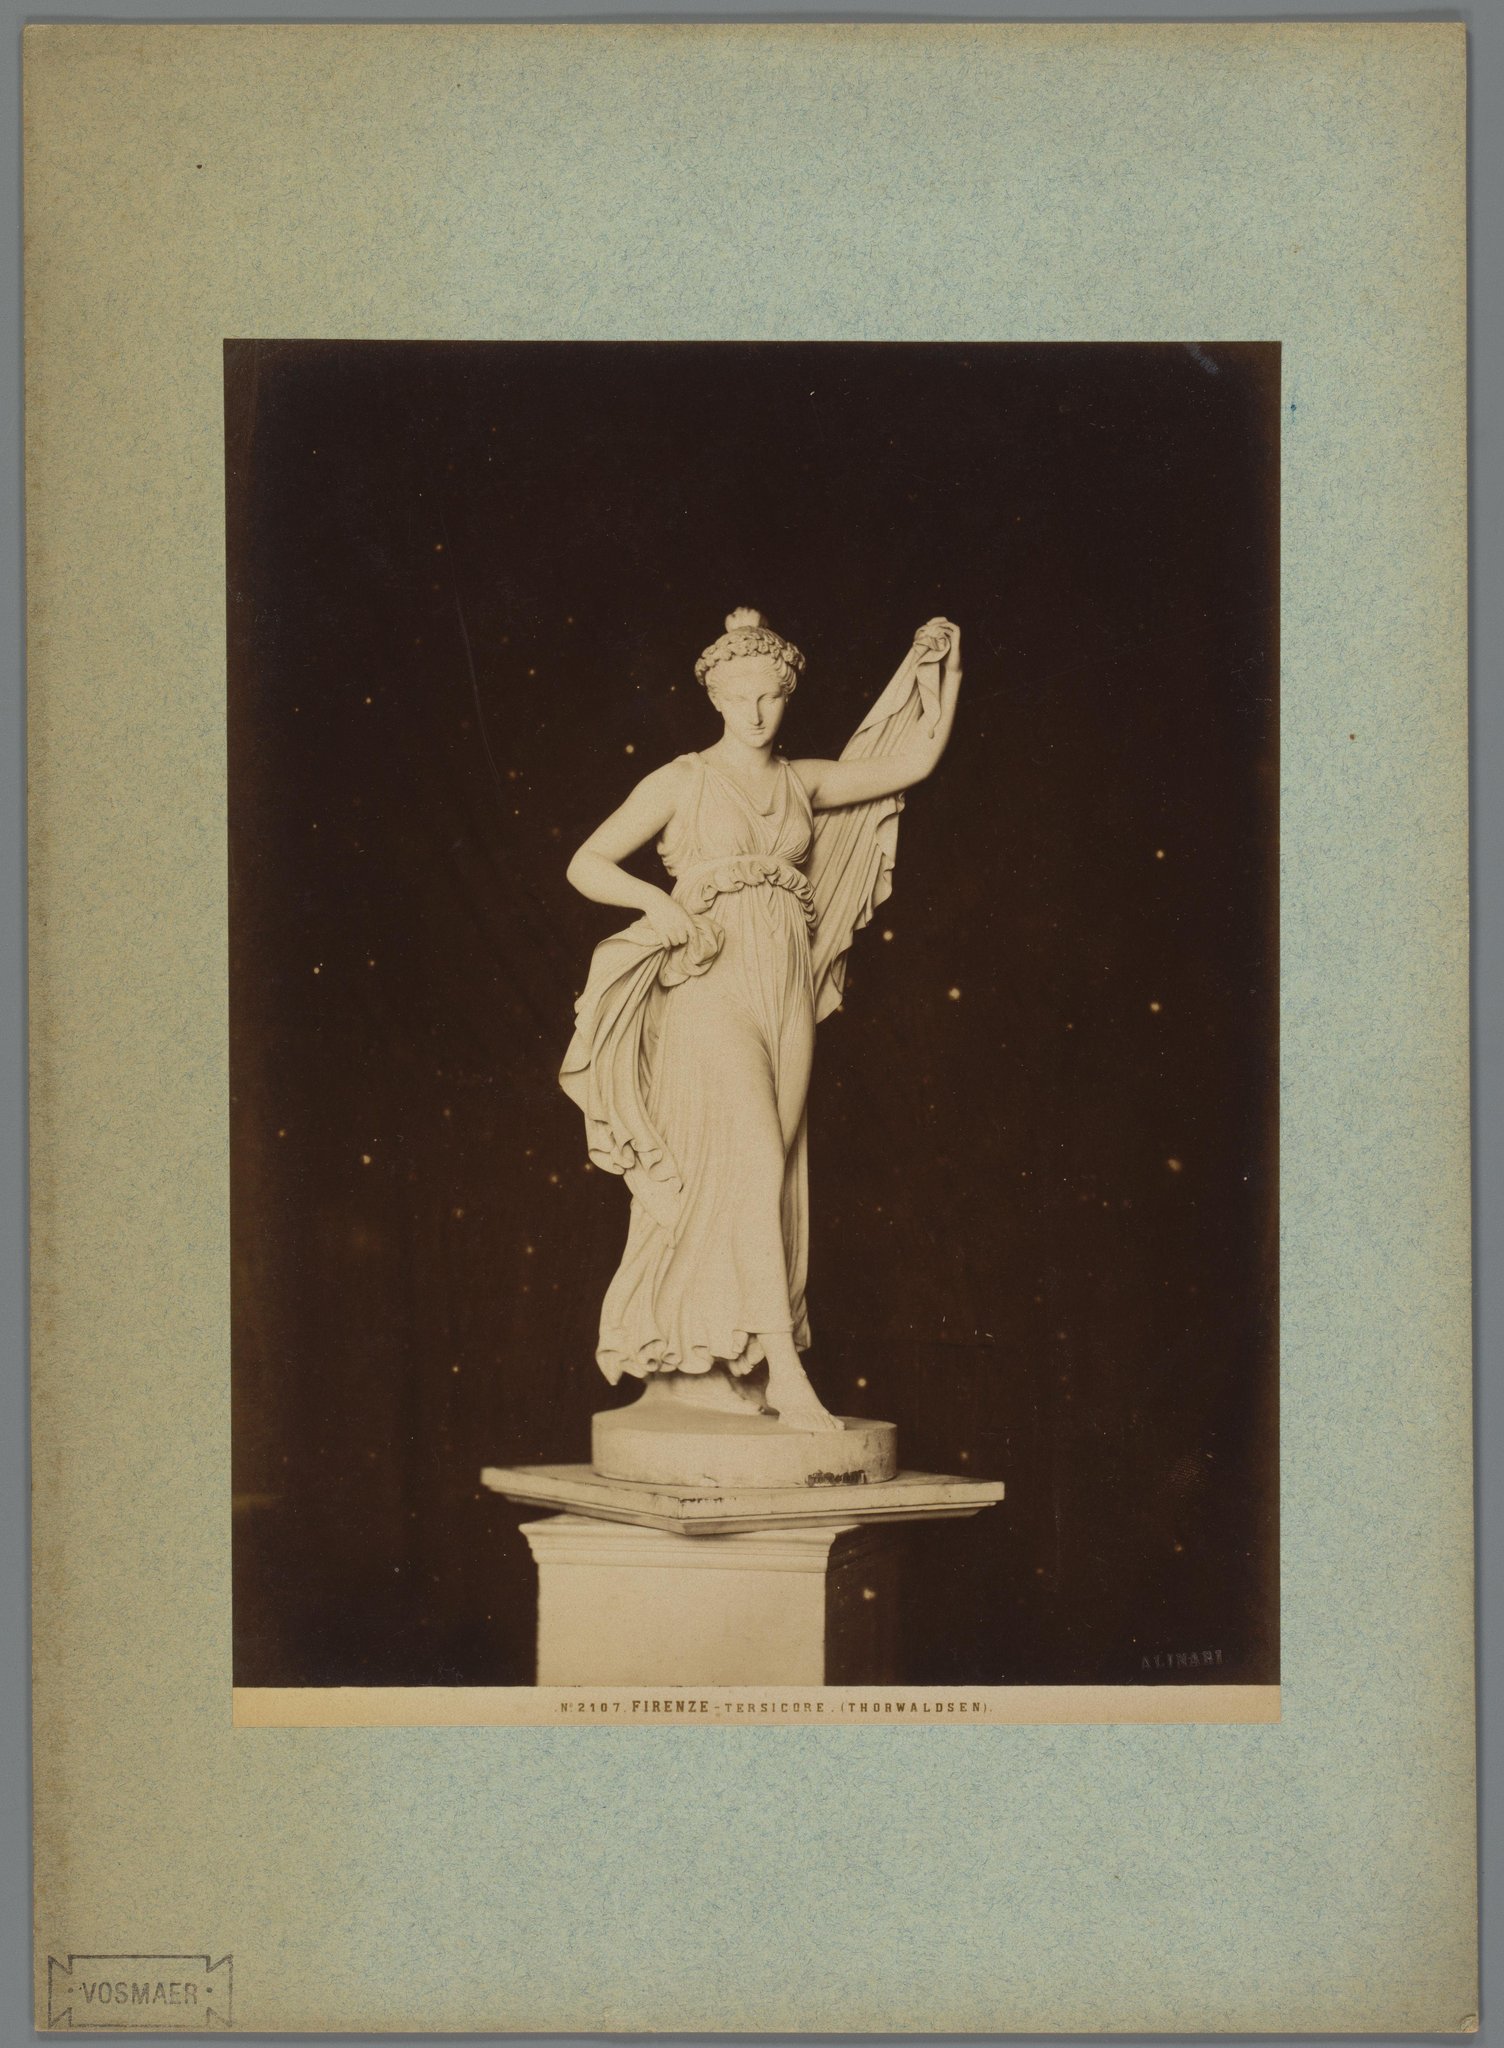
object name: photograph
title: Firenze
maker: bertel thorvaldsen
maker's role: draughtsman, sculptor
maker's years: 1768-1844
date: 1852-1900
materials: cardboard, paper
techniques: albumen print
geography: florence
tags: piece of sculpture, reproduction of a piece of sculpture, terpsichore (one of the muses); 'terpsicore' (ripa)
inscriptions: number: ‘No. 2107’, collector's mark: ‘VOSMAER’